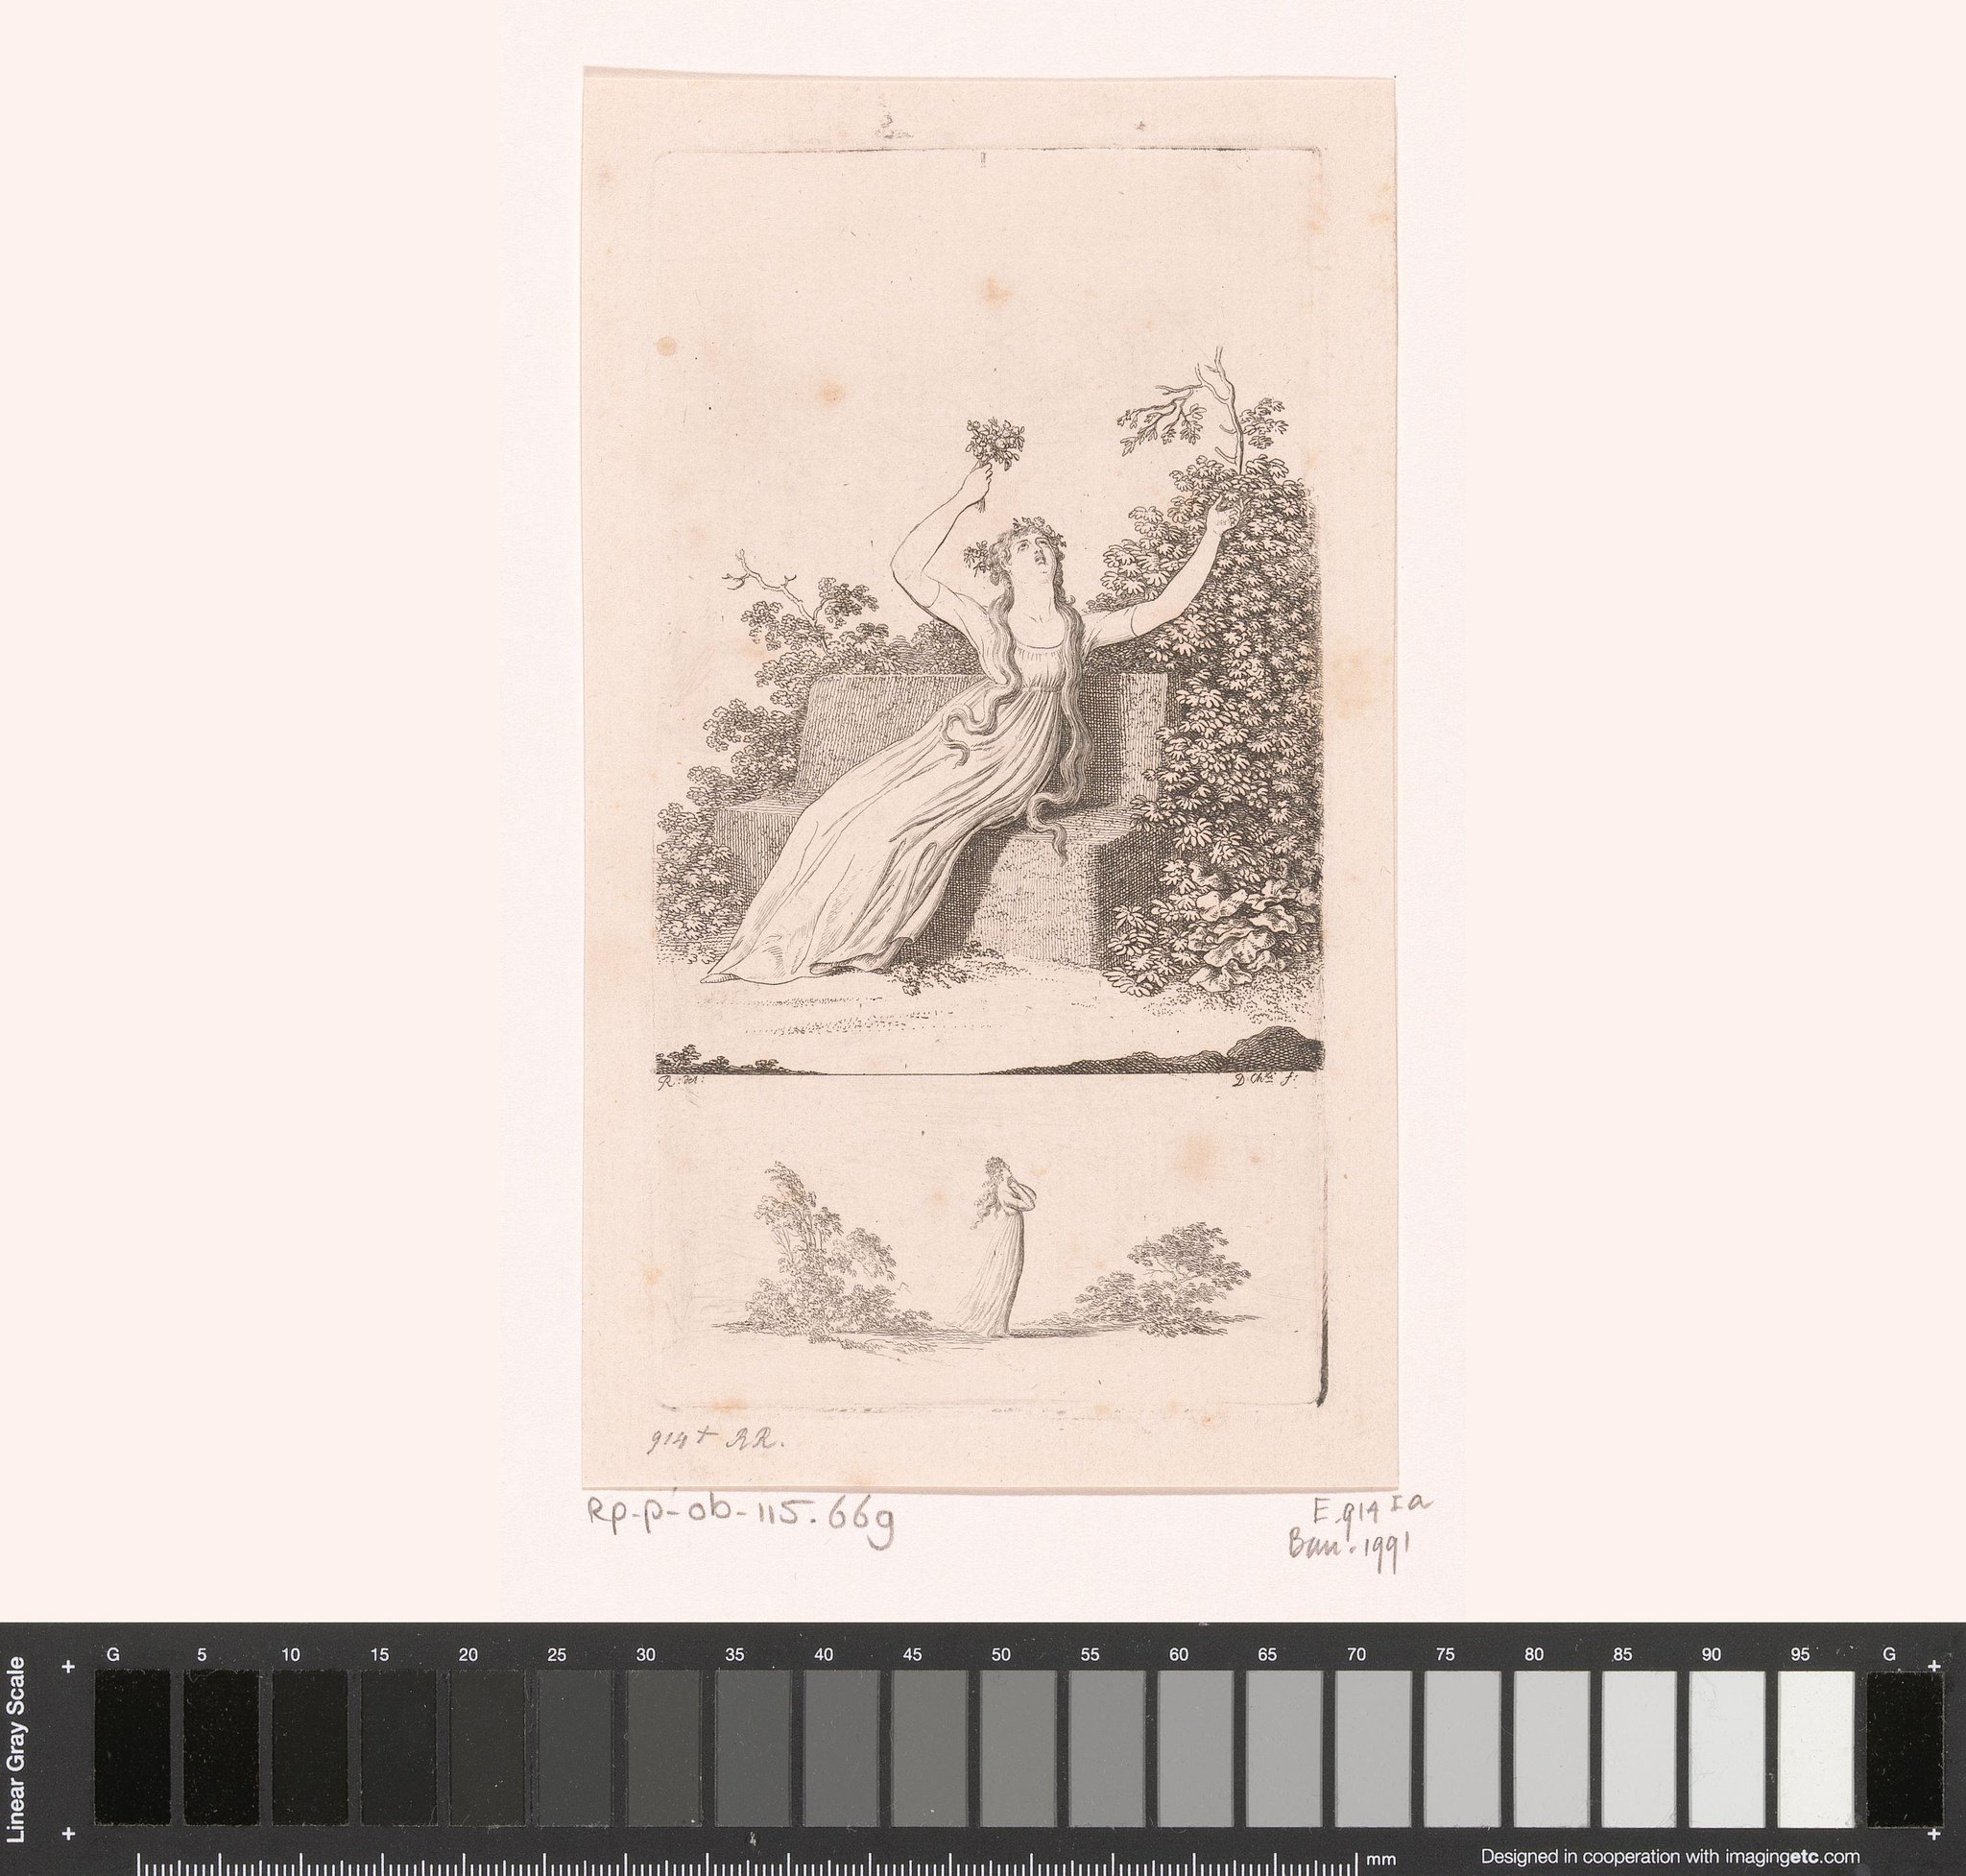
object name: print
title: Nina heft haar handen in wanhoop tot de hemel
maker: daniel nikolaus chodowiecki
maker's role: draughtsman, print maker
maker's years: 1726-1801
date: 1799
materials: paper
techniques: etching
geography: berlin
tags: berlin, bench, cut flowers; nosegay, bunch of flowers, despair; 'disperatione' (ripa)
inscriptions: collector's mark: Lugt 2228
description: Prent gebruikt voor: Rhode, Johann Gottlieb. Berlin, eine Zeitschrift für Freunde der schöne Künste, des Geschmacks und der Moden (...). Berlijn: Decker, 1799-1800.